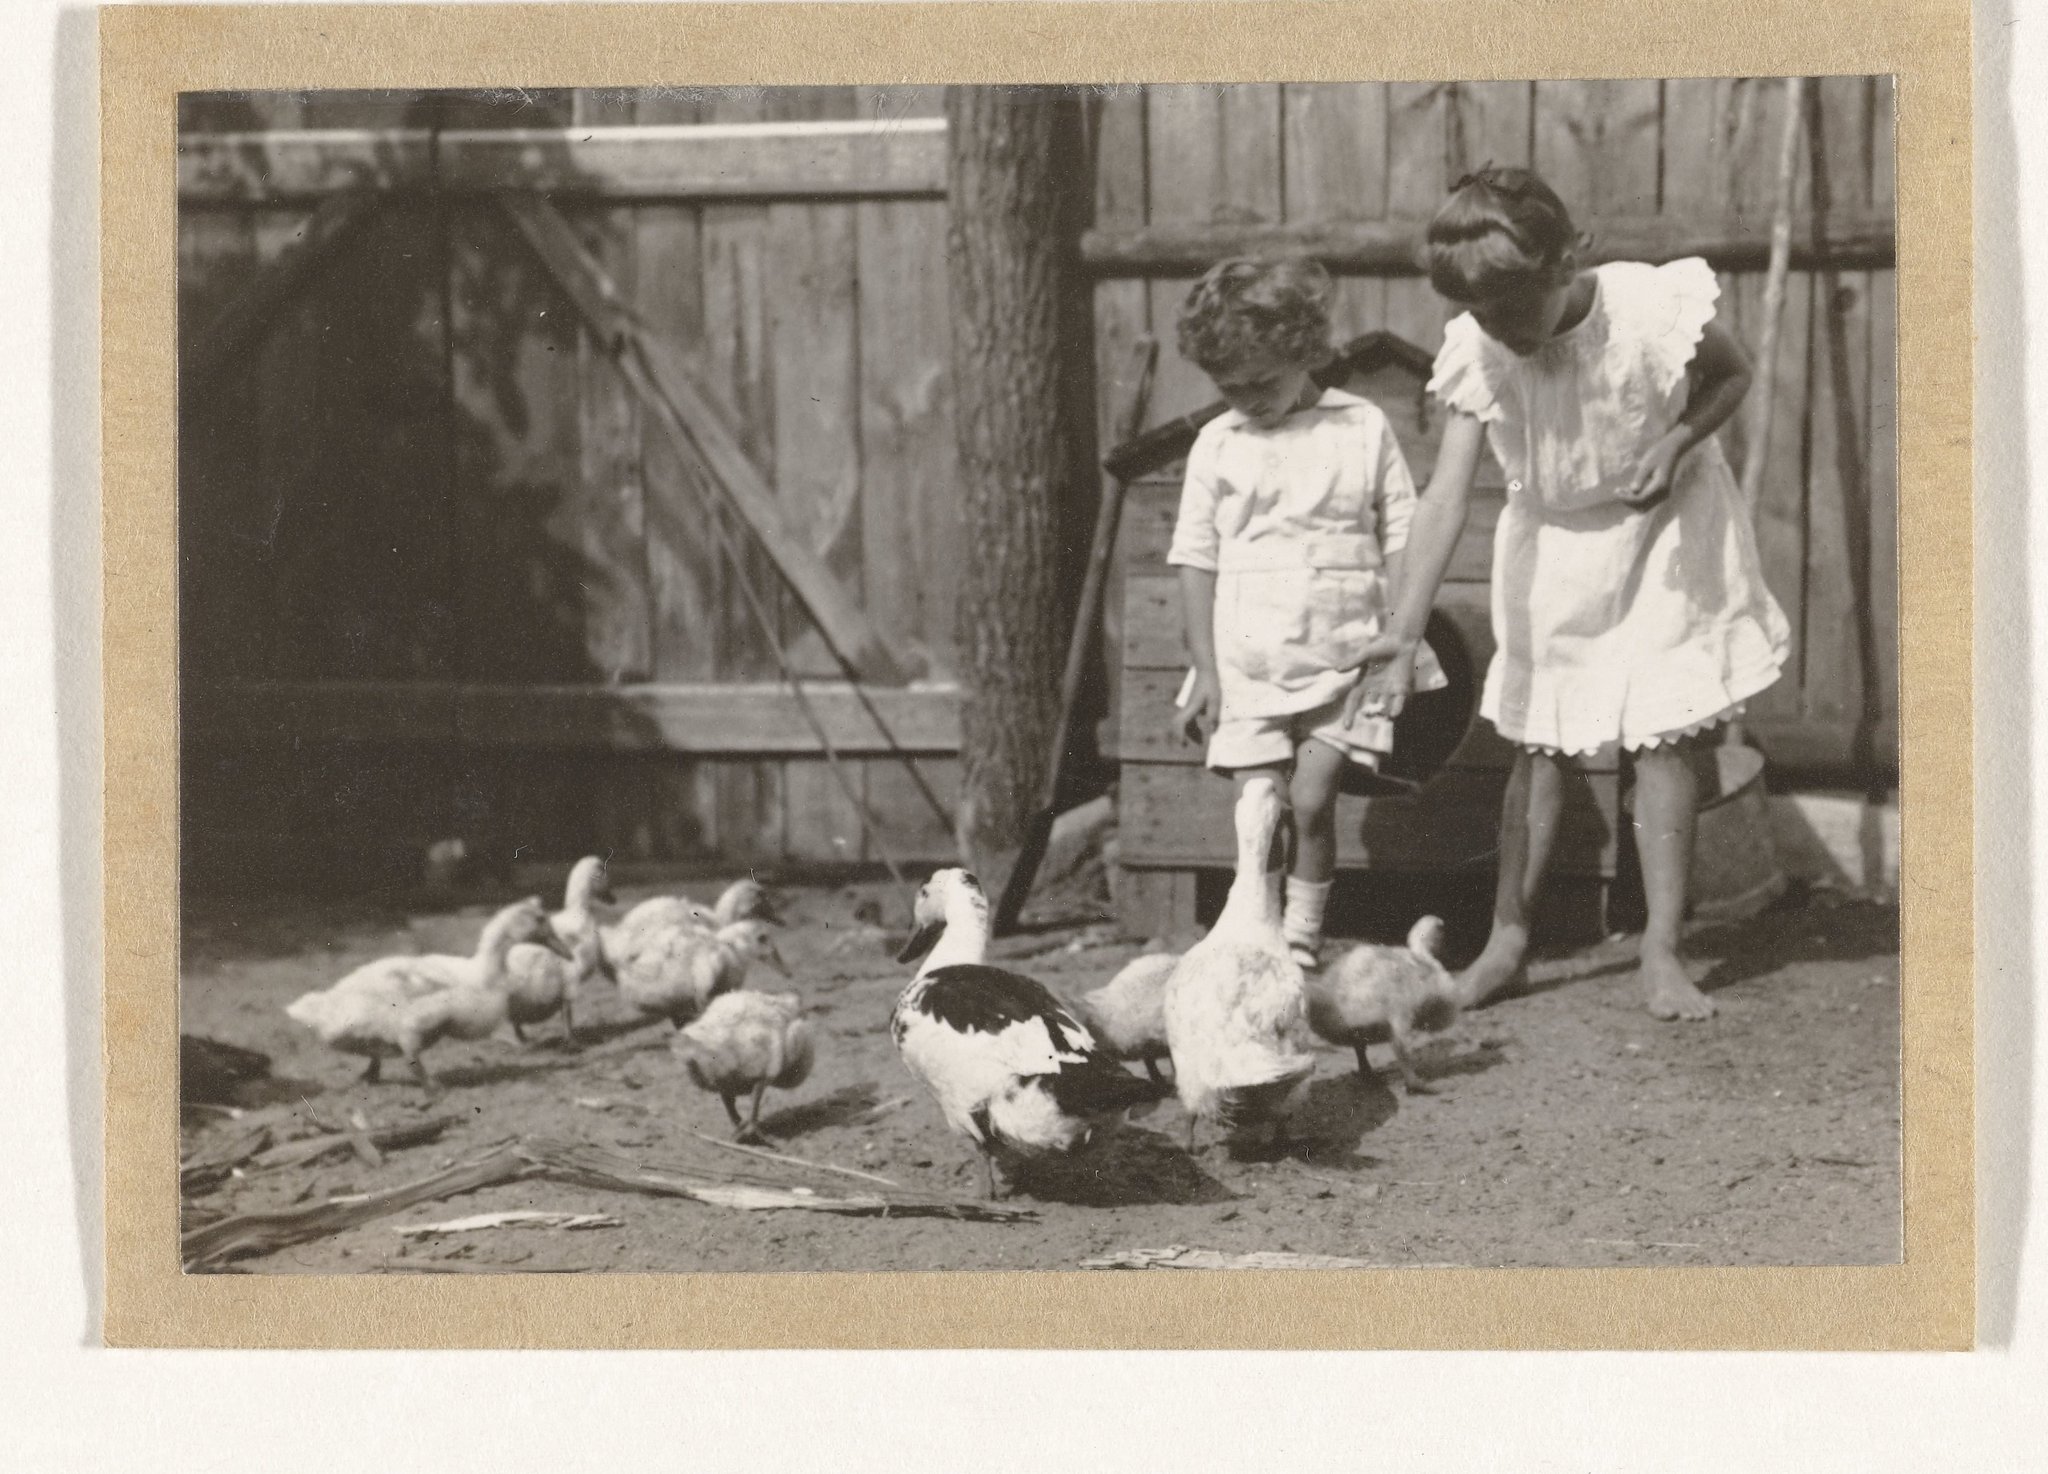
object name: photograph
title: Marba en Eckart Titzenthaler, kinderen van de fotograaf, op een erf met kippen en eenden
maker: waldemar titzenthaler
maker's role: fotograaf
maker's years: 1869-1937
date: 1918-1919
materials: paper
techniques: gelatin silver print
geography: germany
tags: berlin, engineer, boy (child between toddler and youth), girl (child between toddler and youth), fowl (cock, hen, chicken, etc.), germany